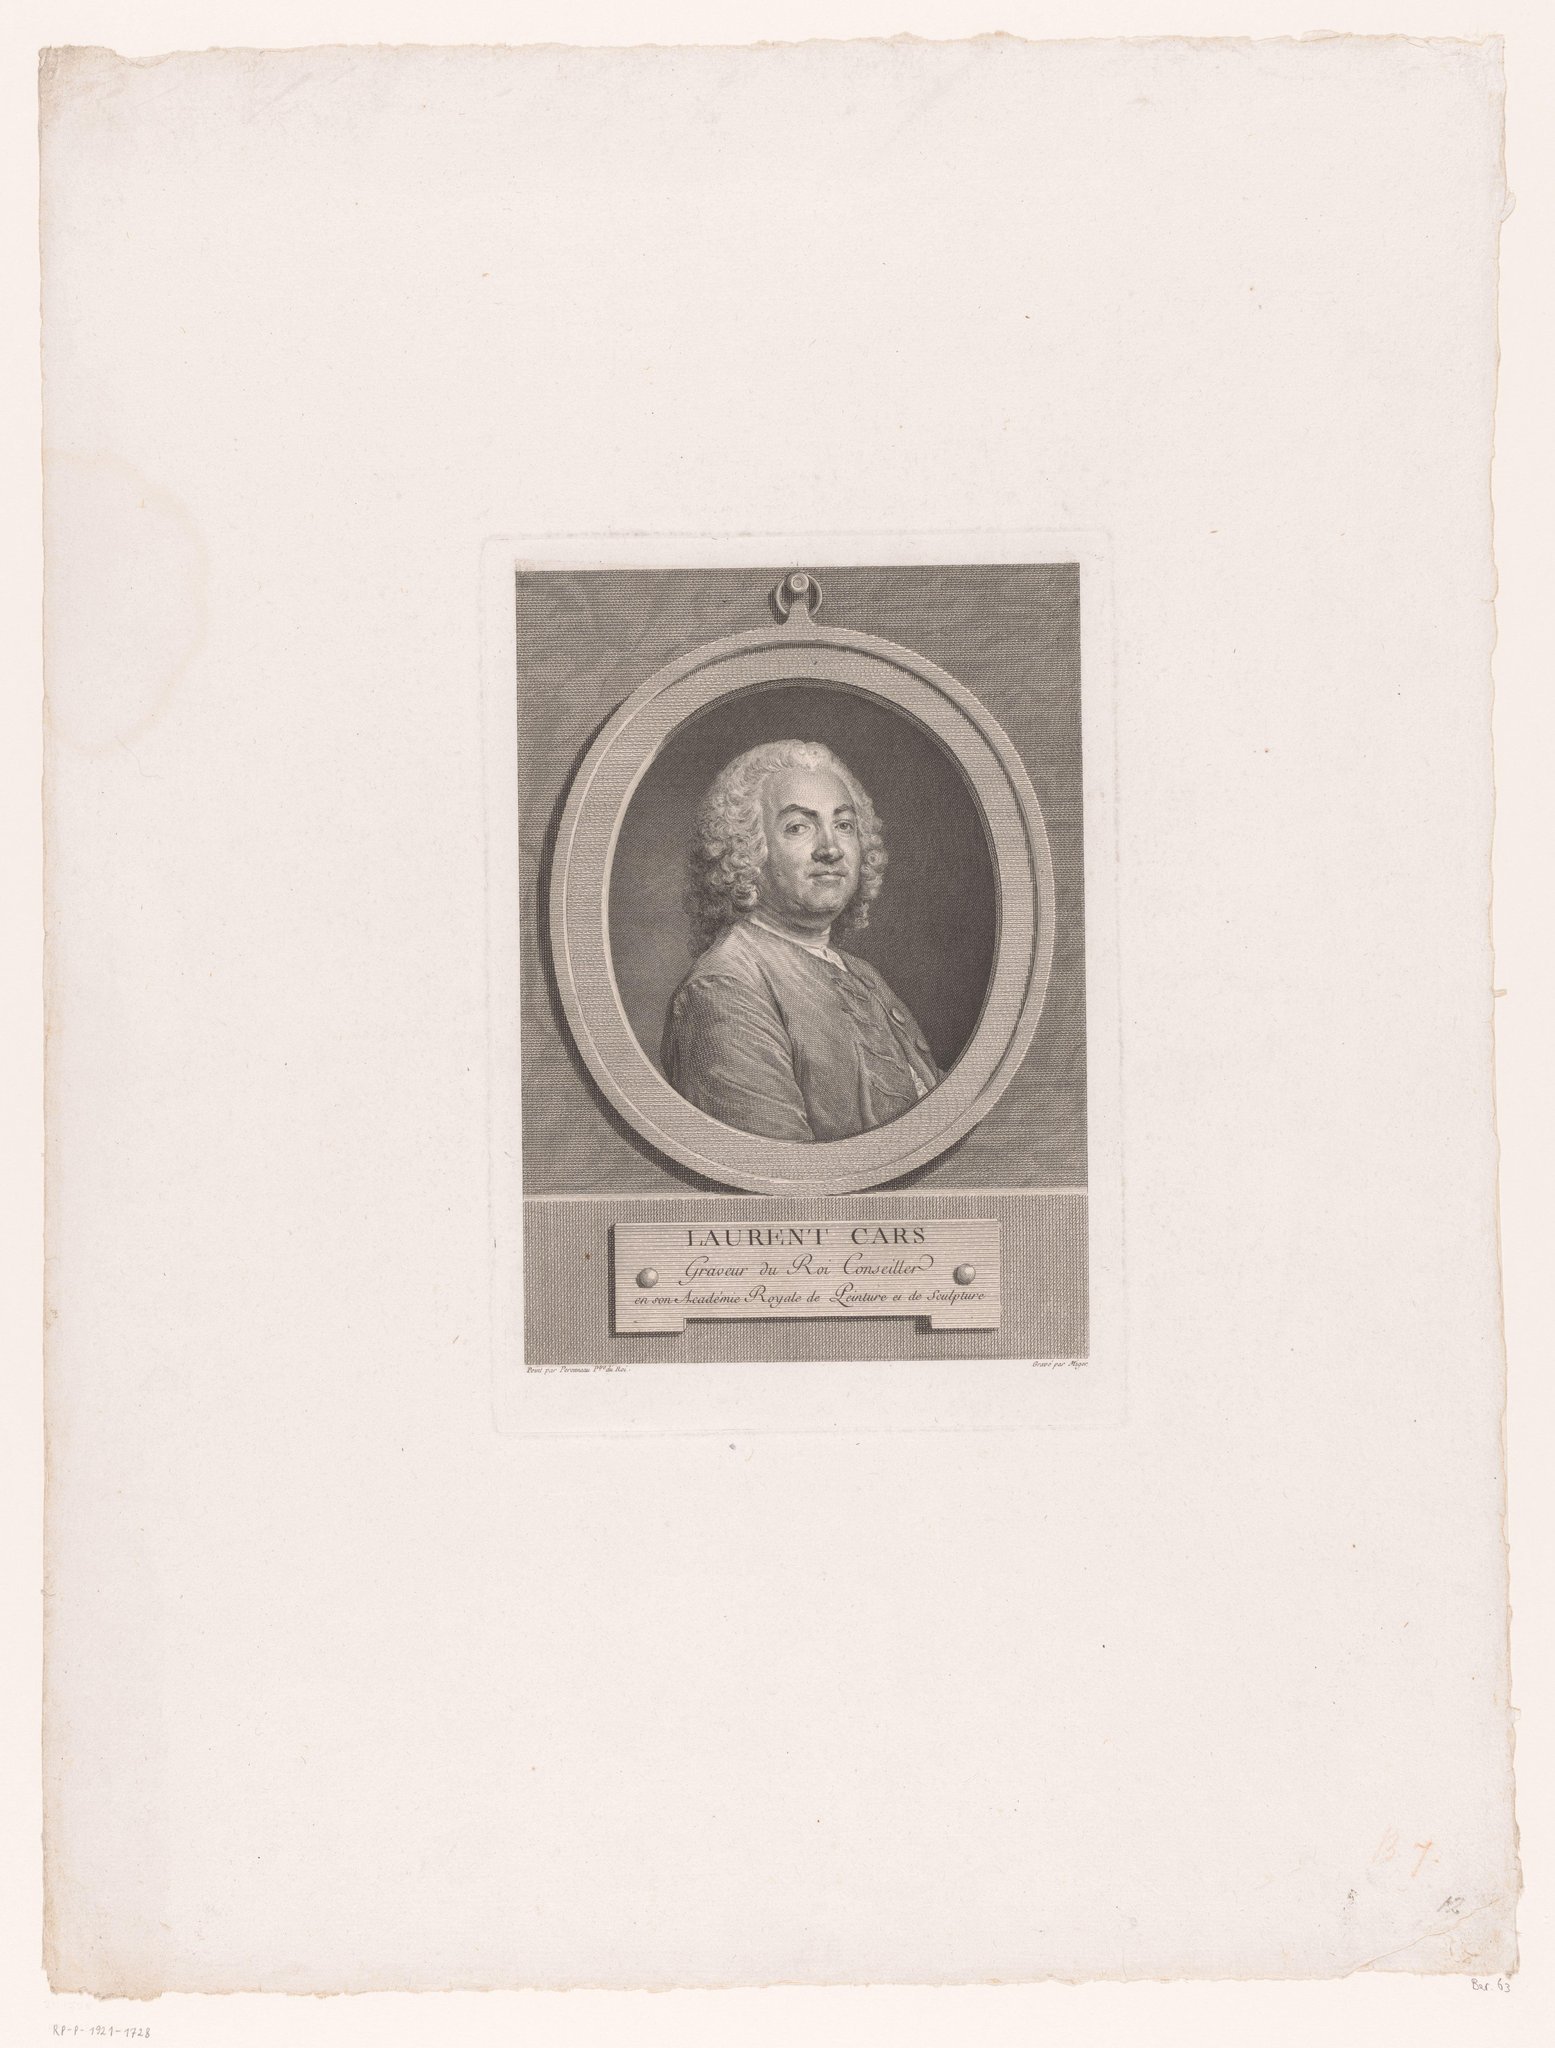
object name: print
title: Portret van Laurent Cars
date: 1746-1820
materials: paper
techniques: engraving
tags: print maker, publisher, laurent cars, historical persons, portrait, self-portrait of graphic artist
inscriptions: collector's mark: Lugt 2233